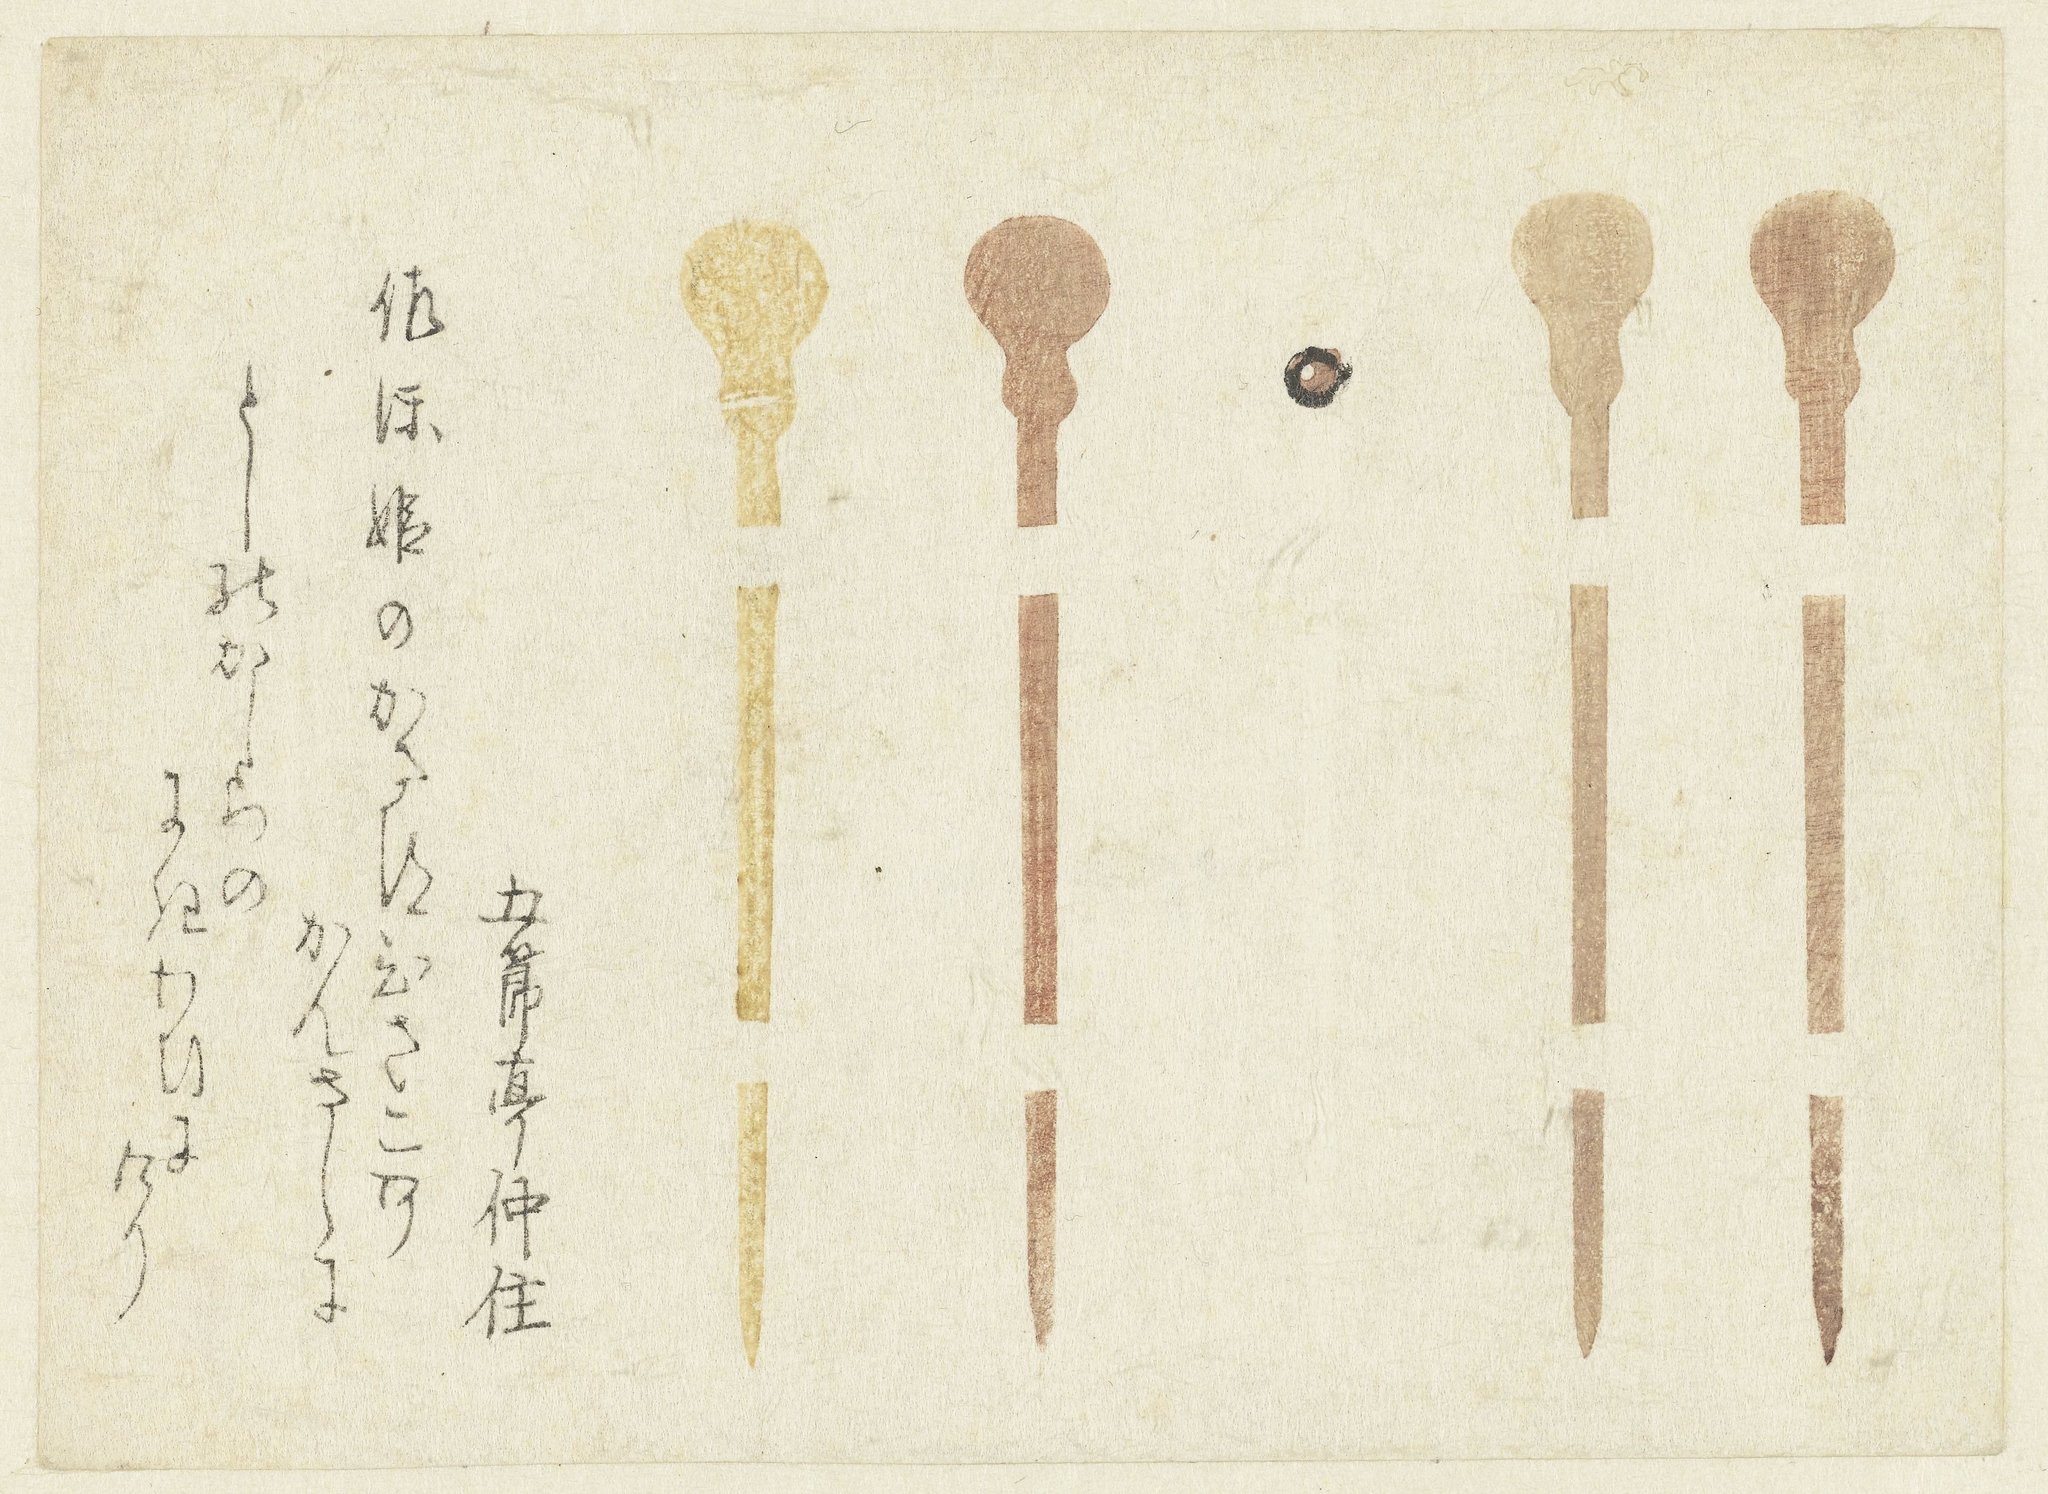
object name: print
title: Five Hairpins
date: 1790-1800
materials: paper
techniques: blind stamped, woodcut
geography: japan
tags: head-gear and clothing for the upper part of the body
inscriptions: collector's mark, verso, stamped: Lugt 2973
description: Een surimono is een luxe uitgevoerde prent waarop beeld met één of meerdere gedichten gecombineerd is. Bij het drukken van een surimono werd vaak gebruik gemaakt van dikker papier, blinddruk en metaal pigmenten, zoals koper- en zilverpoeder. De prenten werden vaak in opdracht van dichters gemaakt en als exclusief geschenk aan vrienden en relaties gegeven.